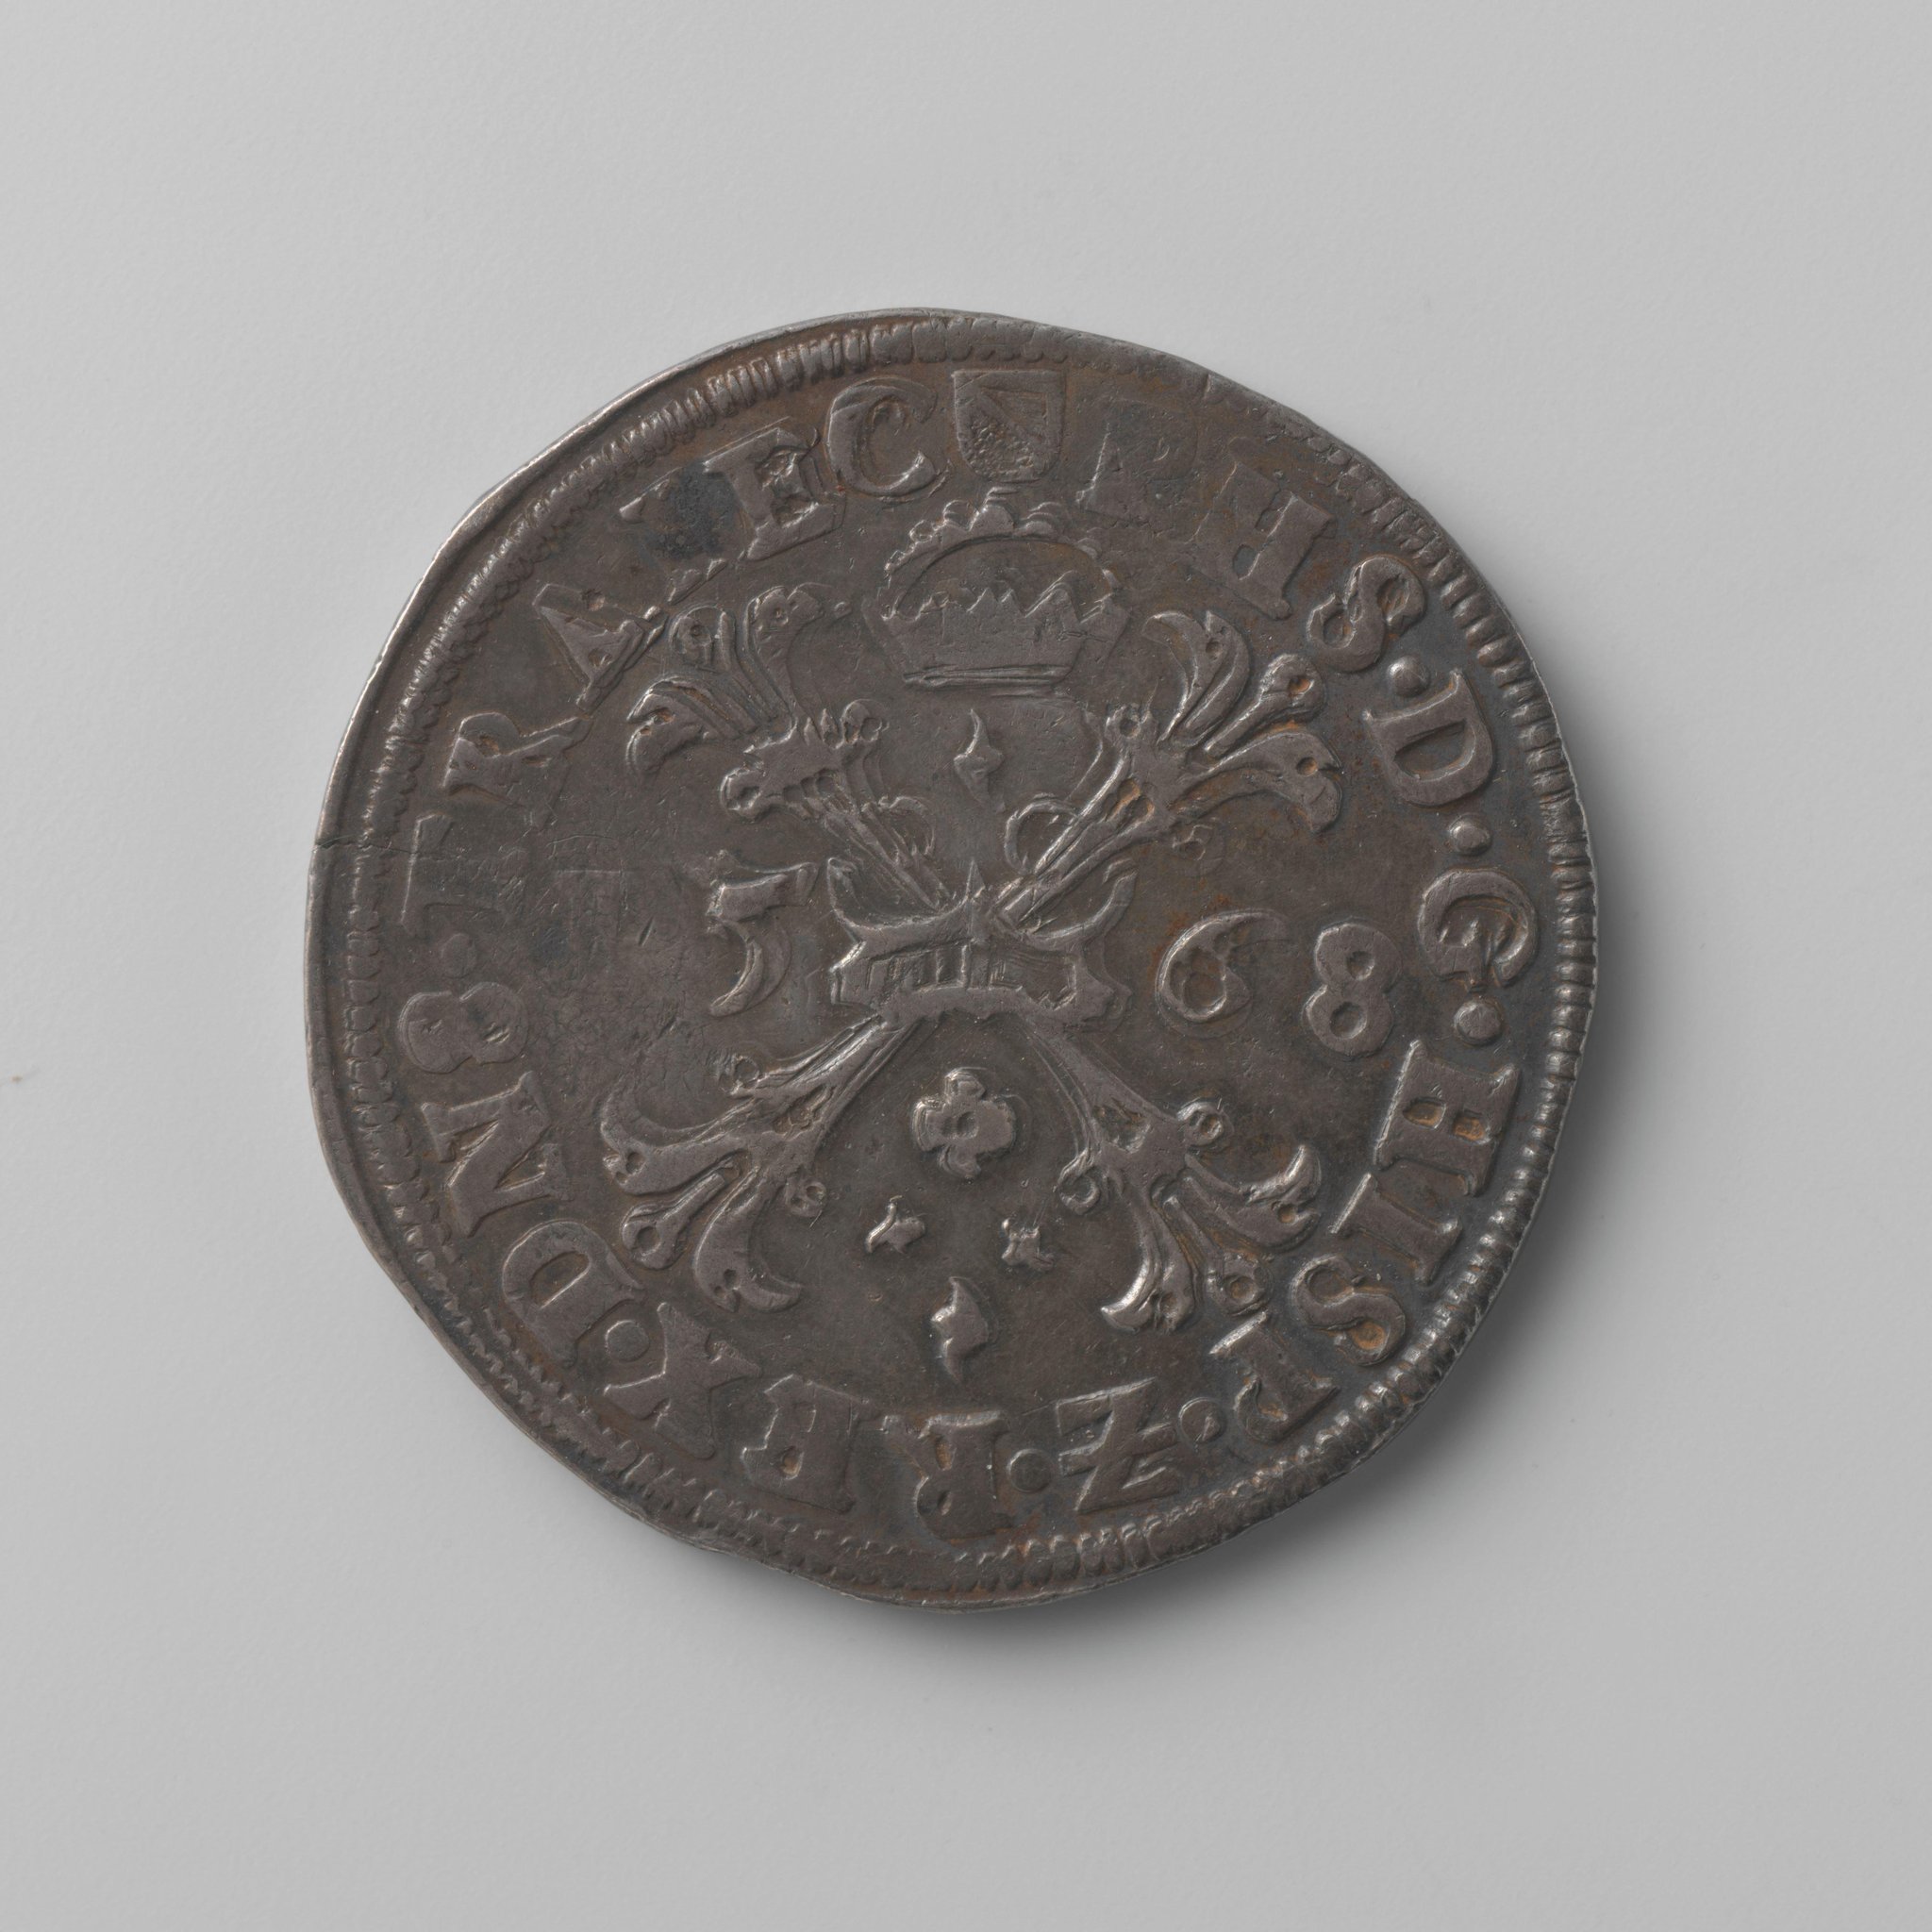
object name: coin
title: Utrechtse bourgondische rijksdaalder van Philips II, 1568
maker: philip ii of spain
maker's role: koning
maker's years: 1527-1598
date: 1568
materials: silver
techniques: striking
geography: dordrecht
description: Zilveren munt. Voorzijde: tussen jaartal onder kroon gekruiste knoestige stokken, in het midden vuursteen met vonken. Keerzijde: gekroond wapenschild van Bourgondië, omhangen met keten van het Gulden Vlies.